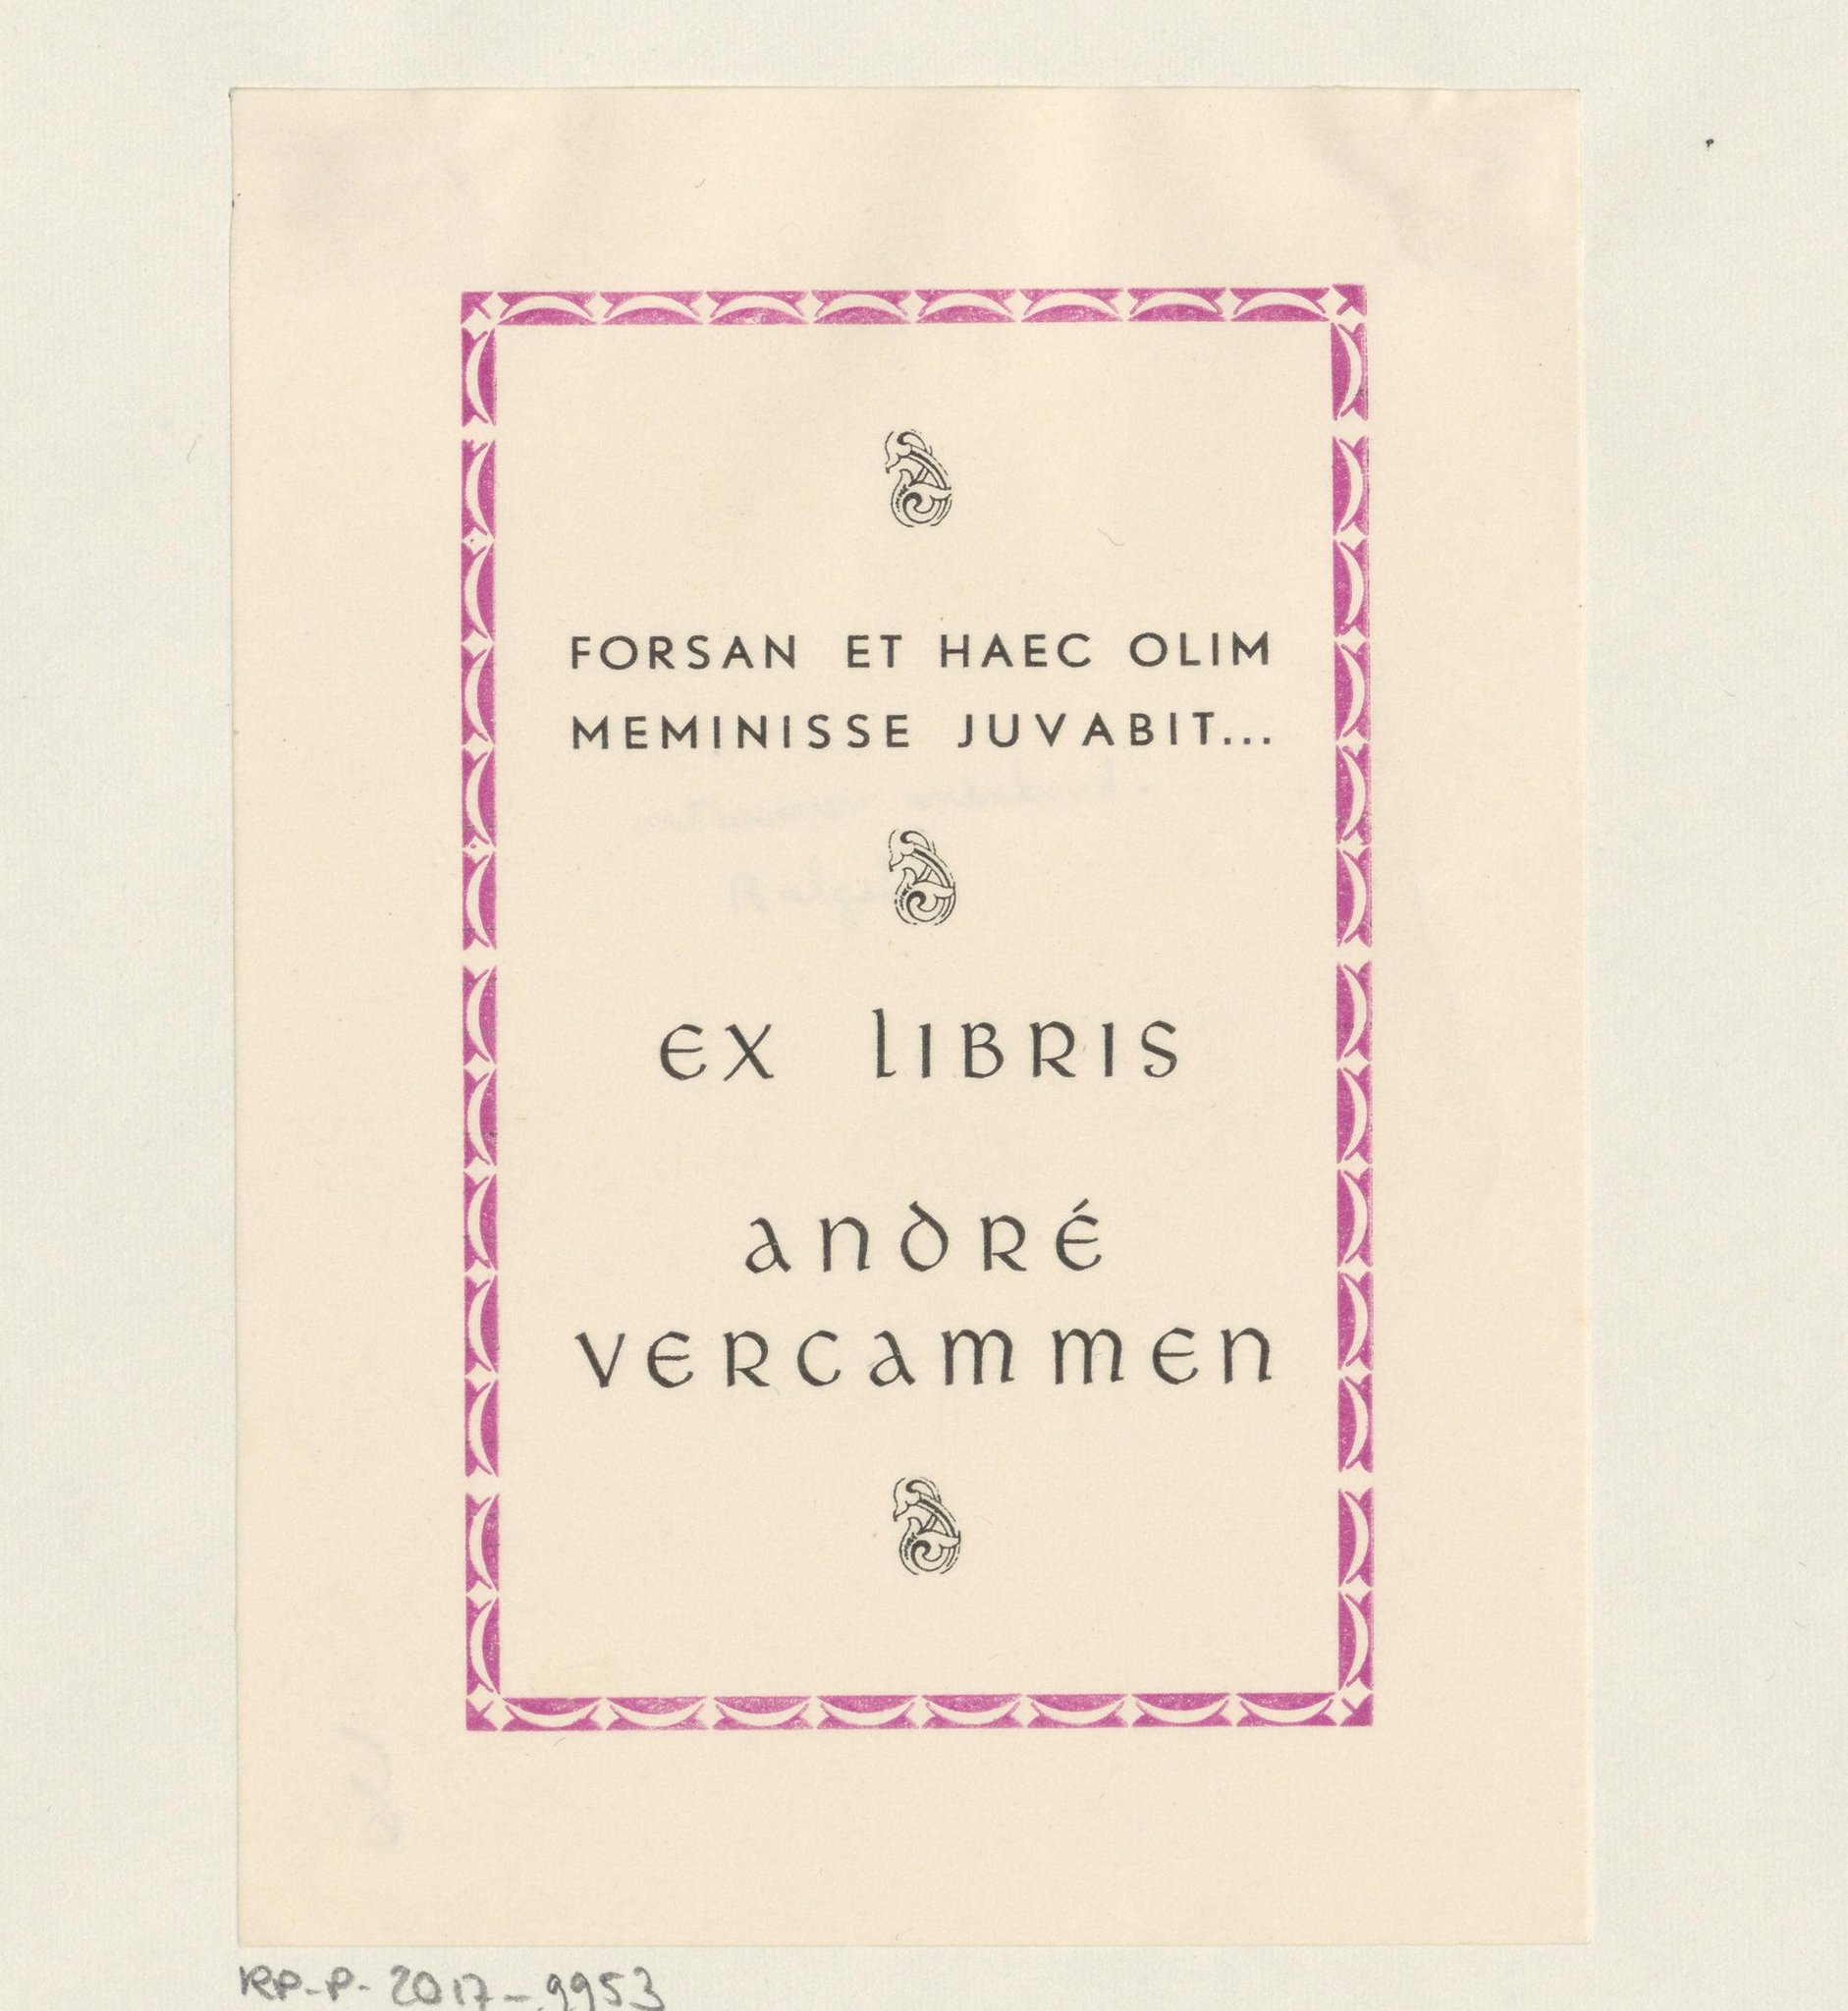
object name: bookplate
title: Ex libris van André Vercammen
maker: Anonymous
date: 1900-1999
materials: paper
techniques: printing block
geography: belgium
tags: andré vercammen